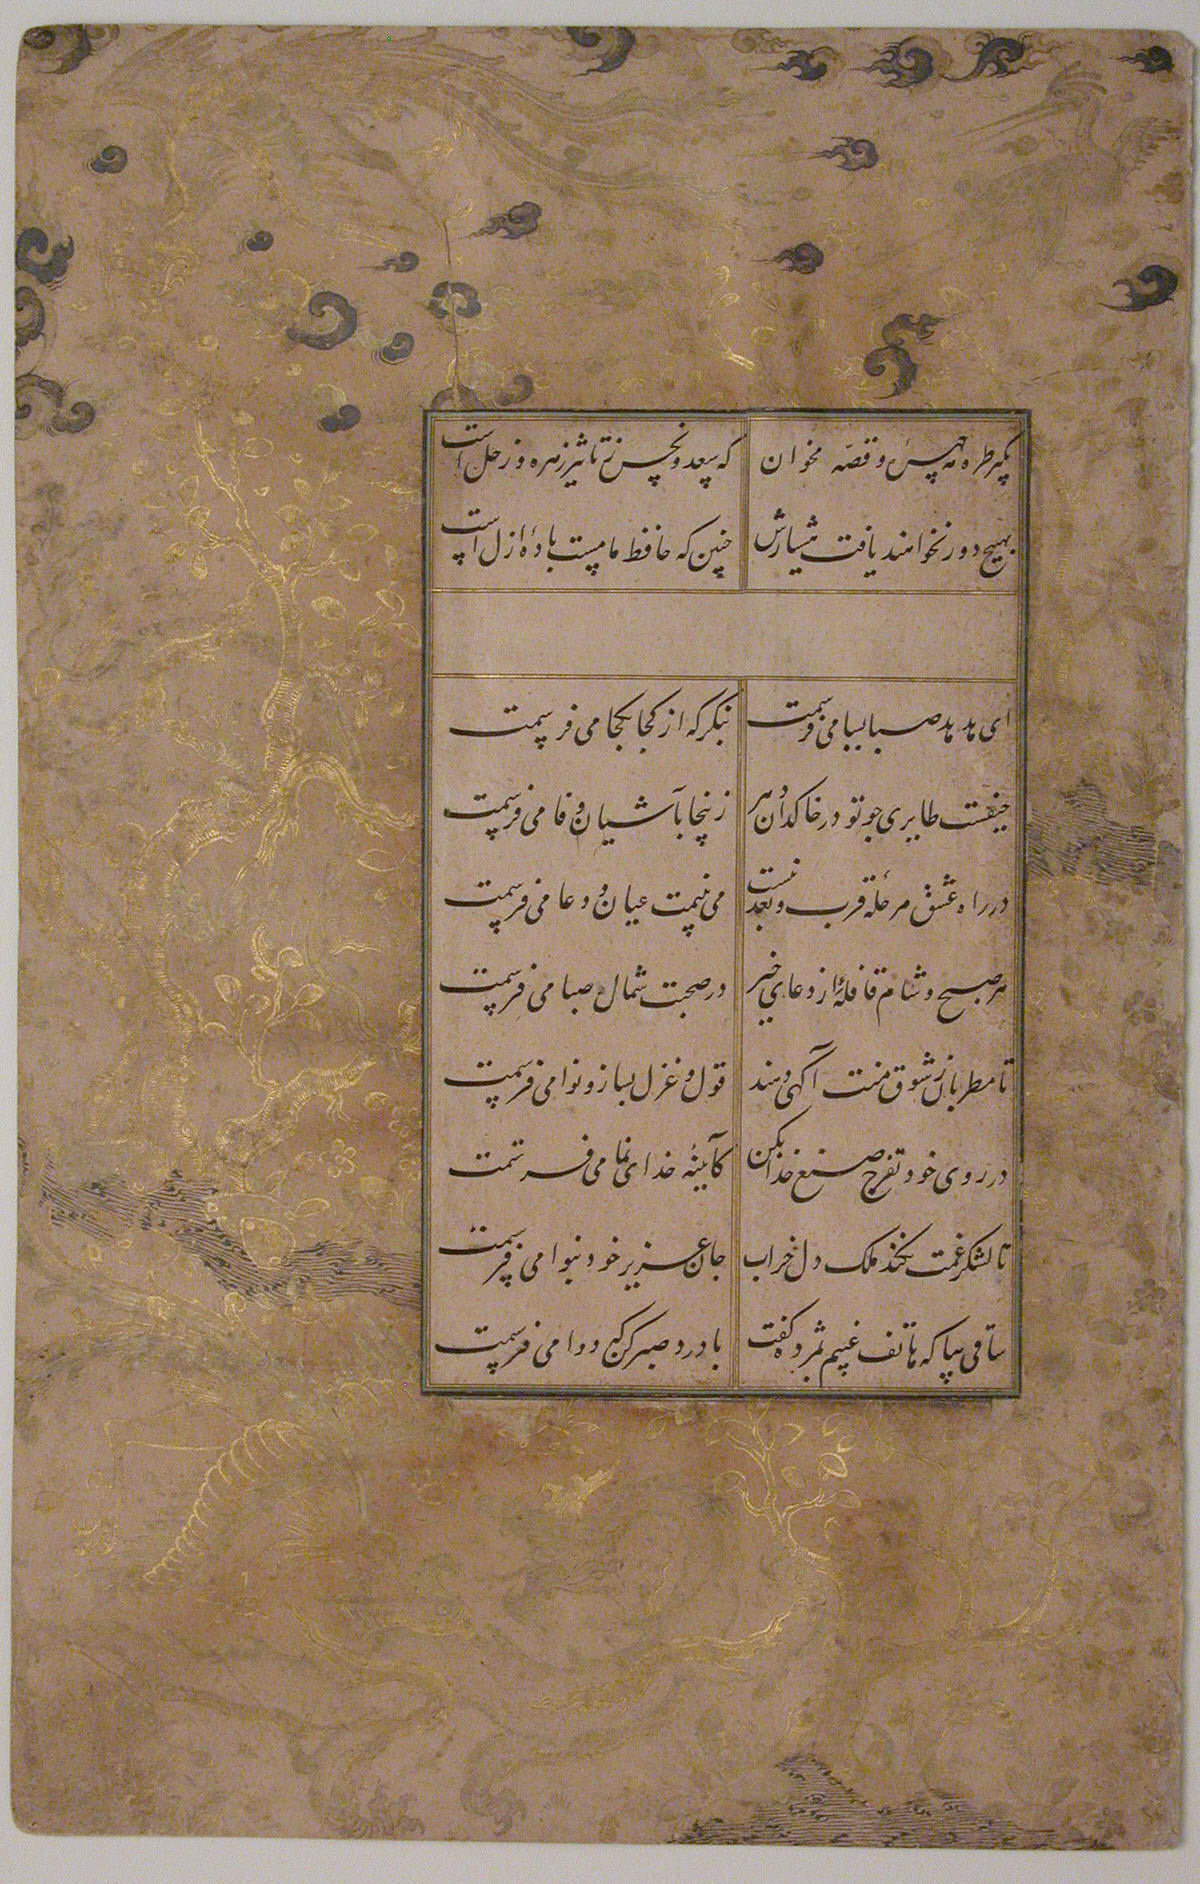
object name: folio from a non illustrated manuscript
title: Page of Calligraphy from an Anthology of Poetry by Sa`di and Hafiz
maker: sa'di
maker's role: author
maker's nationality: iranian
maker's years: 1213-1291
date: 1467-1500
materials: gold, ink, paper, silver, watercolor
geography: afghanistan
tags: poetry,calligraphy